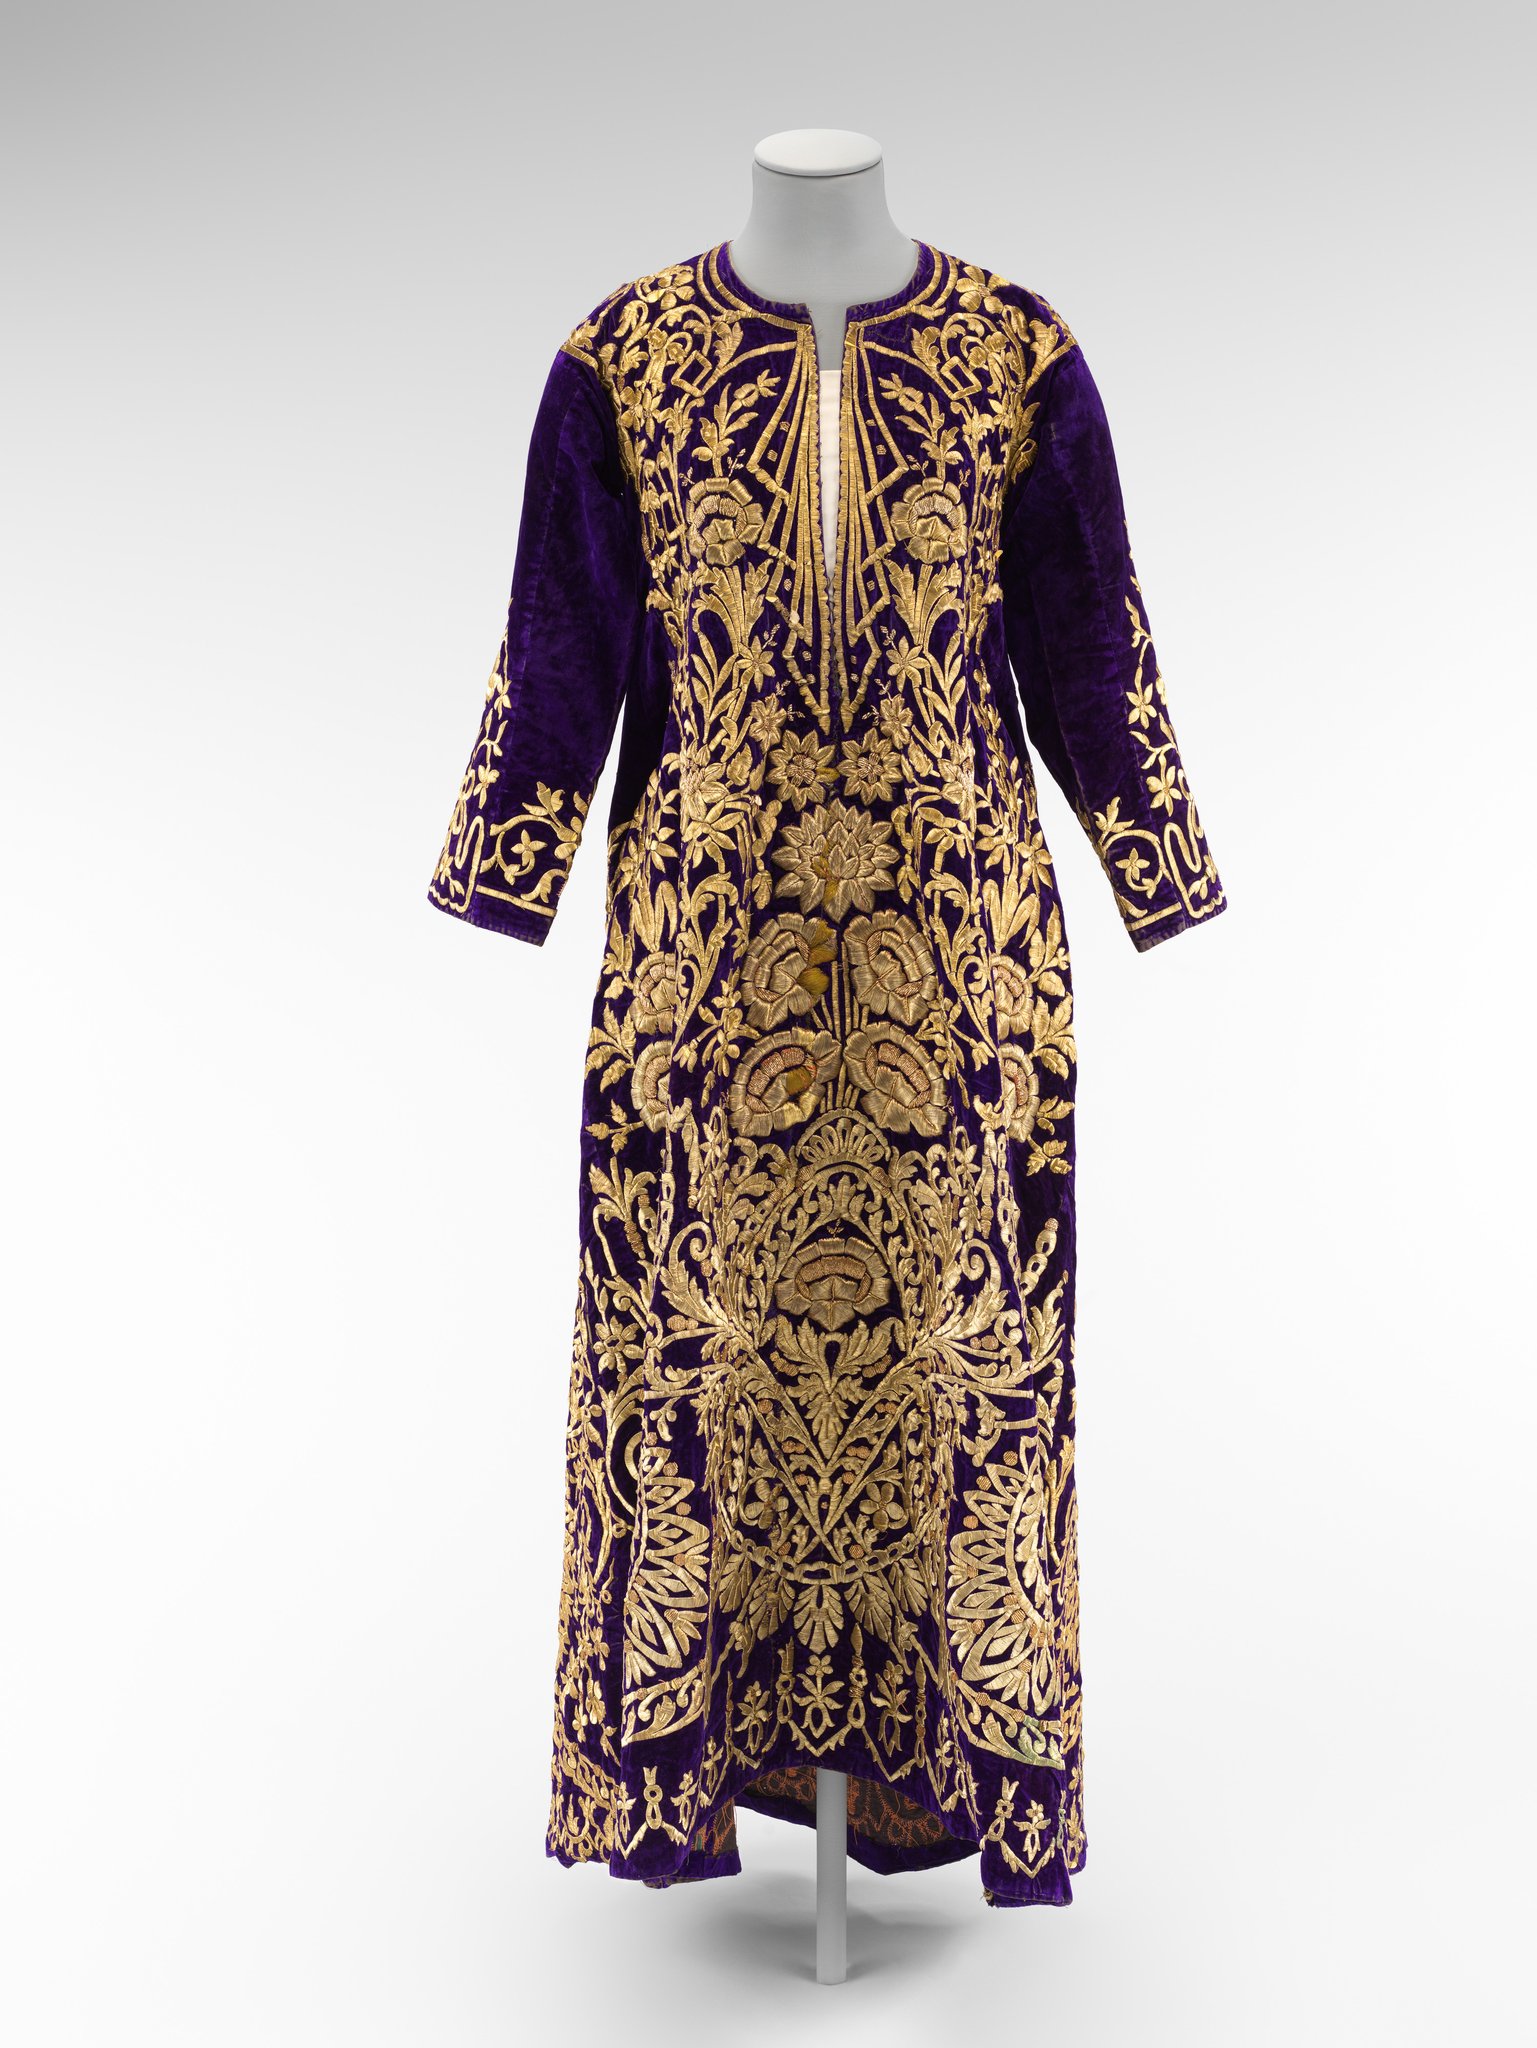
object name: dress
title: Bindalli Wedding Dress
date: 1834-1933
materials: cotton, metal thread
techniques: embroidery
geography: turkey